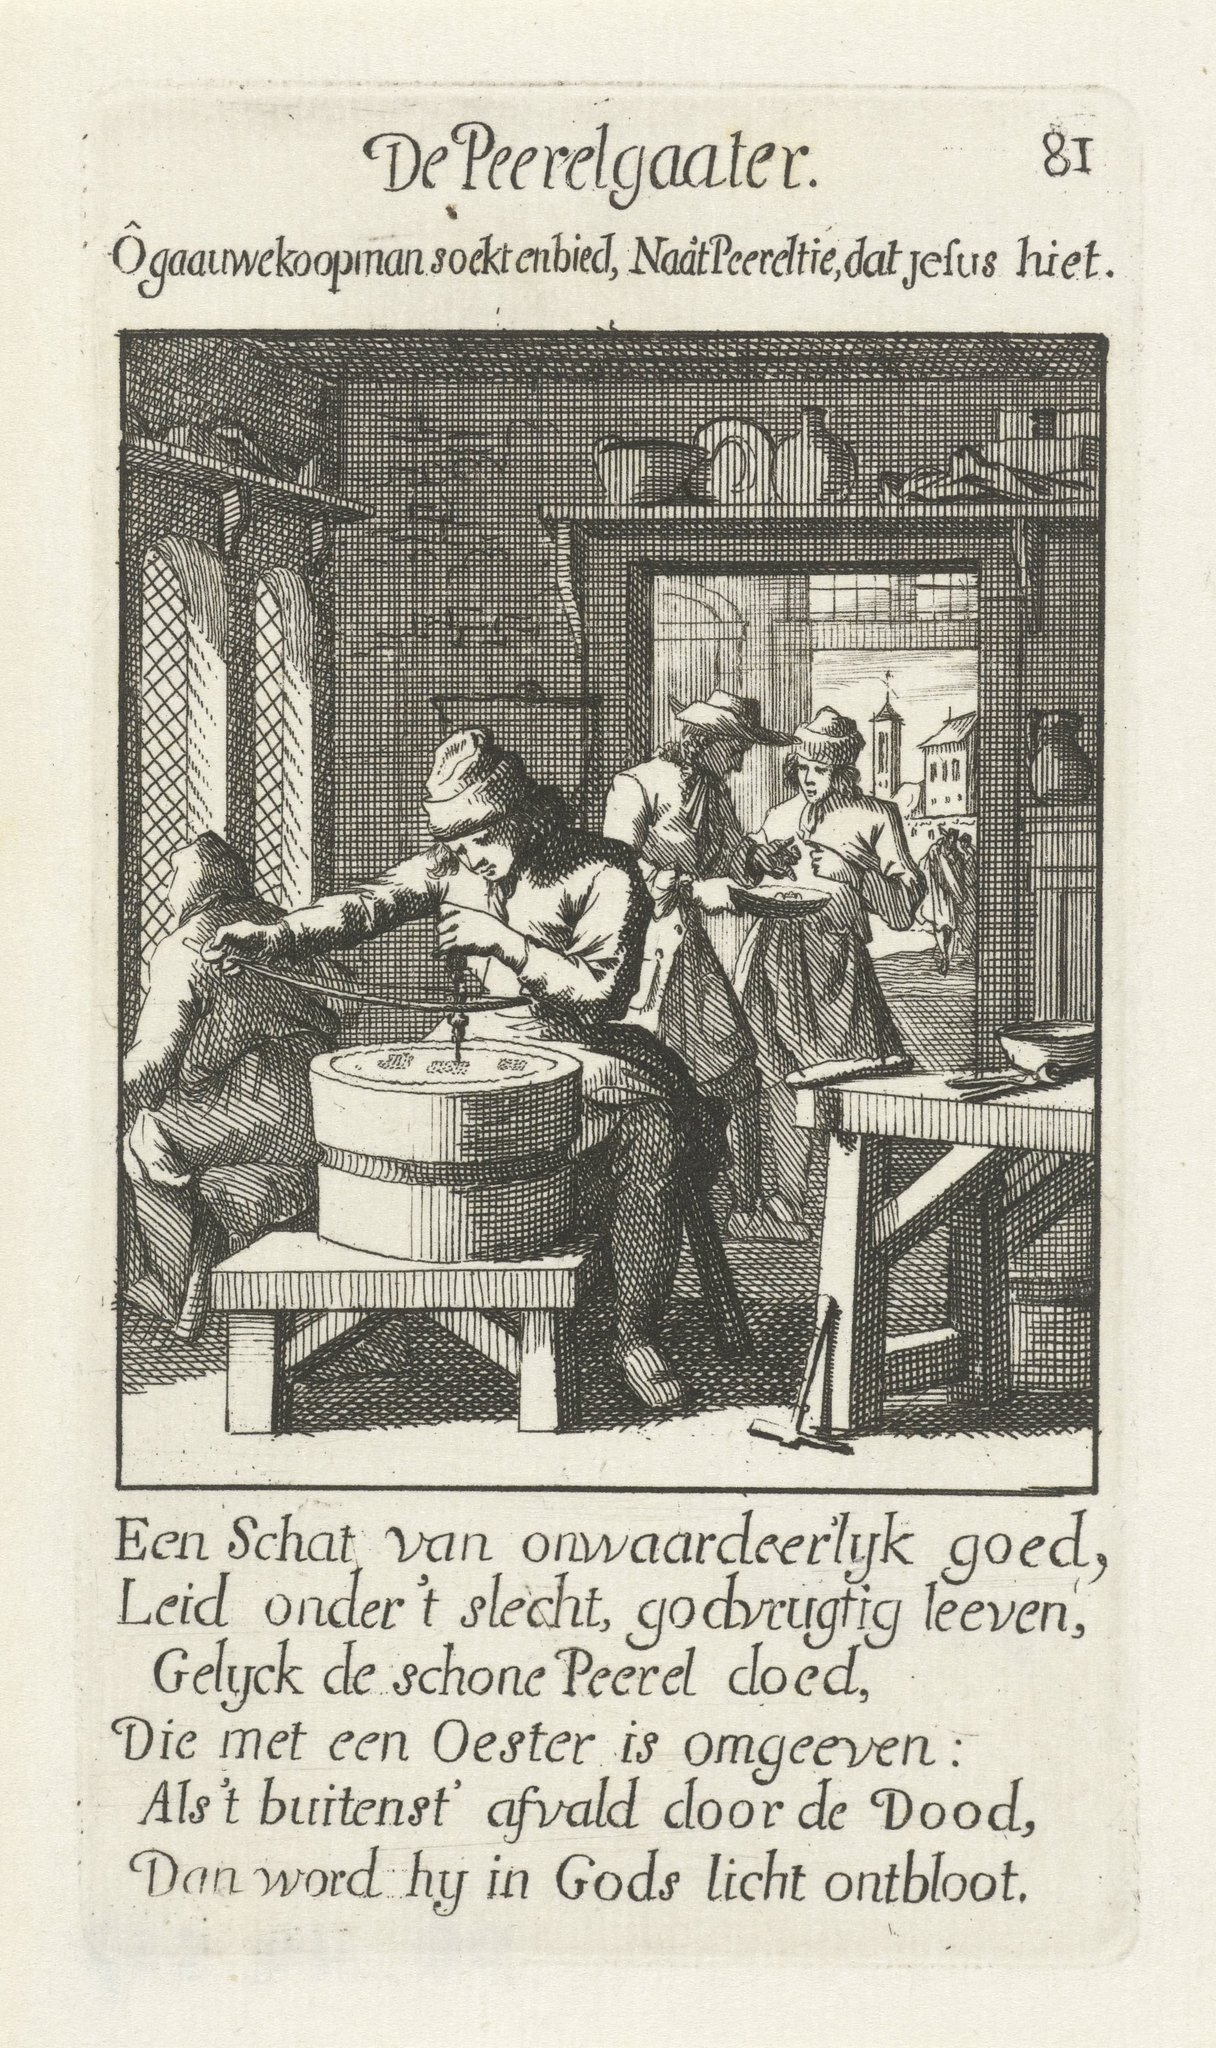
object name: print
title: De Peerelgaater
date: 1694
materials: paper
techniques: etching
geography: amsterdam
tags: handicrafts, craftsman at work, pearl; pearl necklace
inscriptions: collector's mark: Lugt 2228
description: Maakt deel uit van de 100-delige serie beroepsprenten van Jan en Caspar Luyken, getiteld: Het menselyk bedryf. S.l.s.n., 1694 (eerste druk).